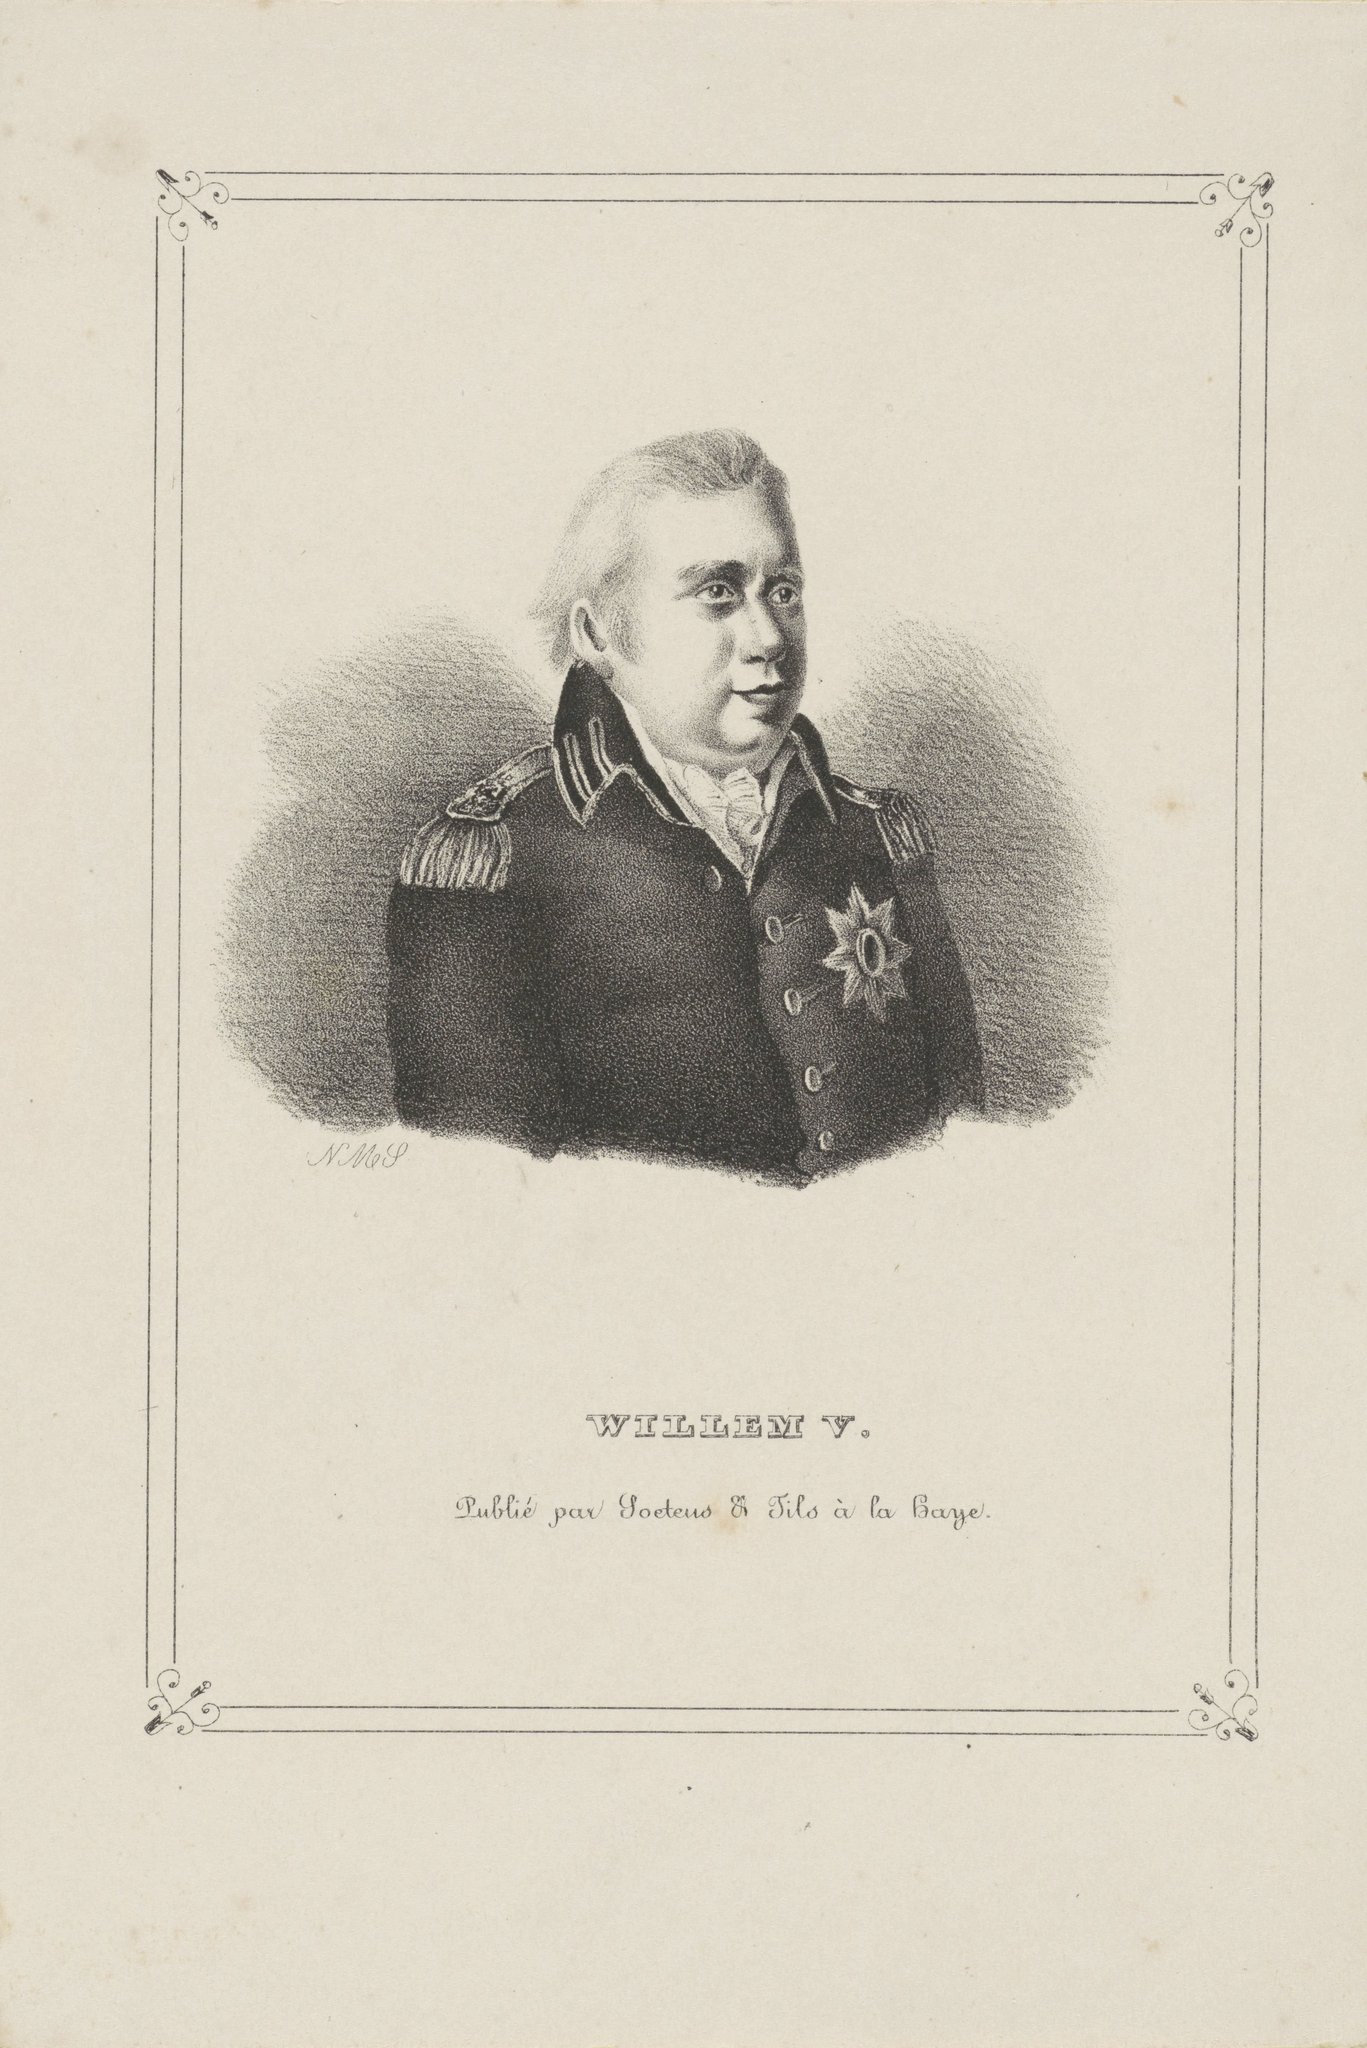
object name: print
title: Portret van Willem V, prins van Oranje-Nassau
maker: nicolaas martinus schild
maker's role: draughtsman, print maker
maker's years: 1822-1840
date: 1837-1840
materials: paper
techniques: lithograph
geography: the hague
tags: the hague, william v (prince of orange)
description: De hier vermelde titel verwijst naar de hoogst verkregen titel van de geportretteerde, niet per se naar de titel die de geportretteerde op deze voorstelling draagt.